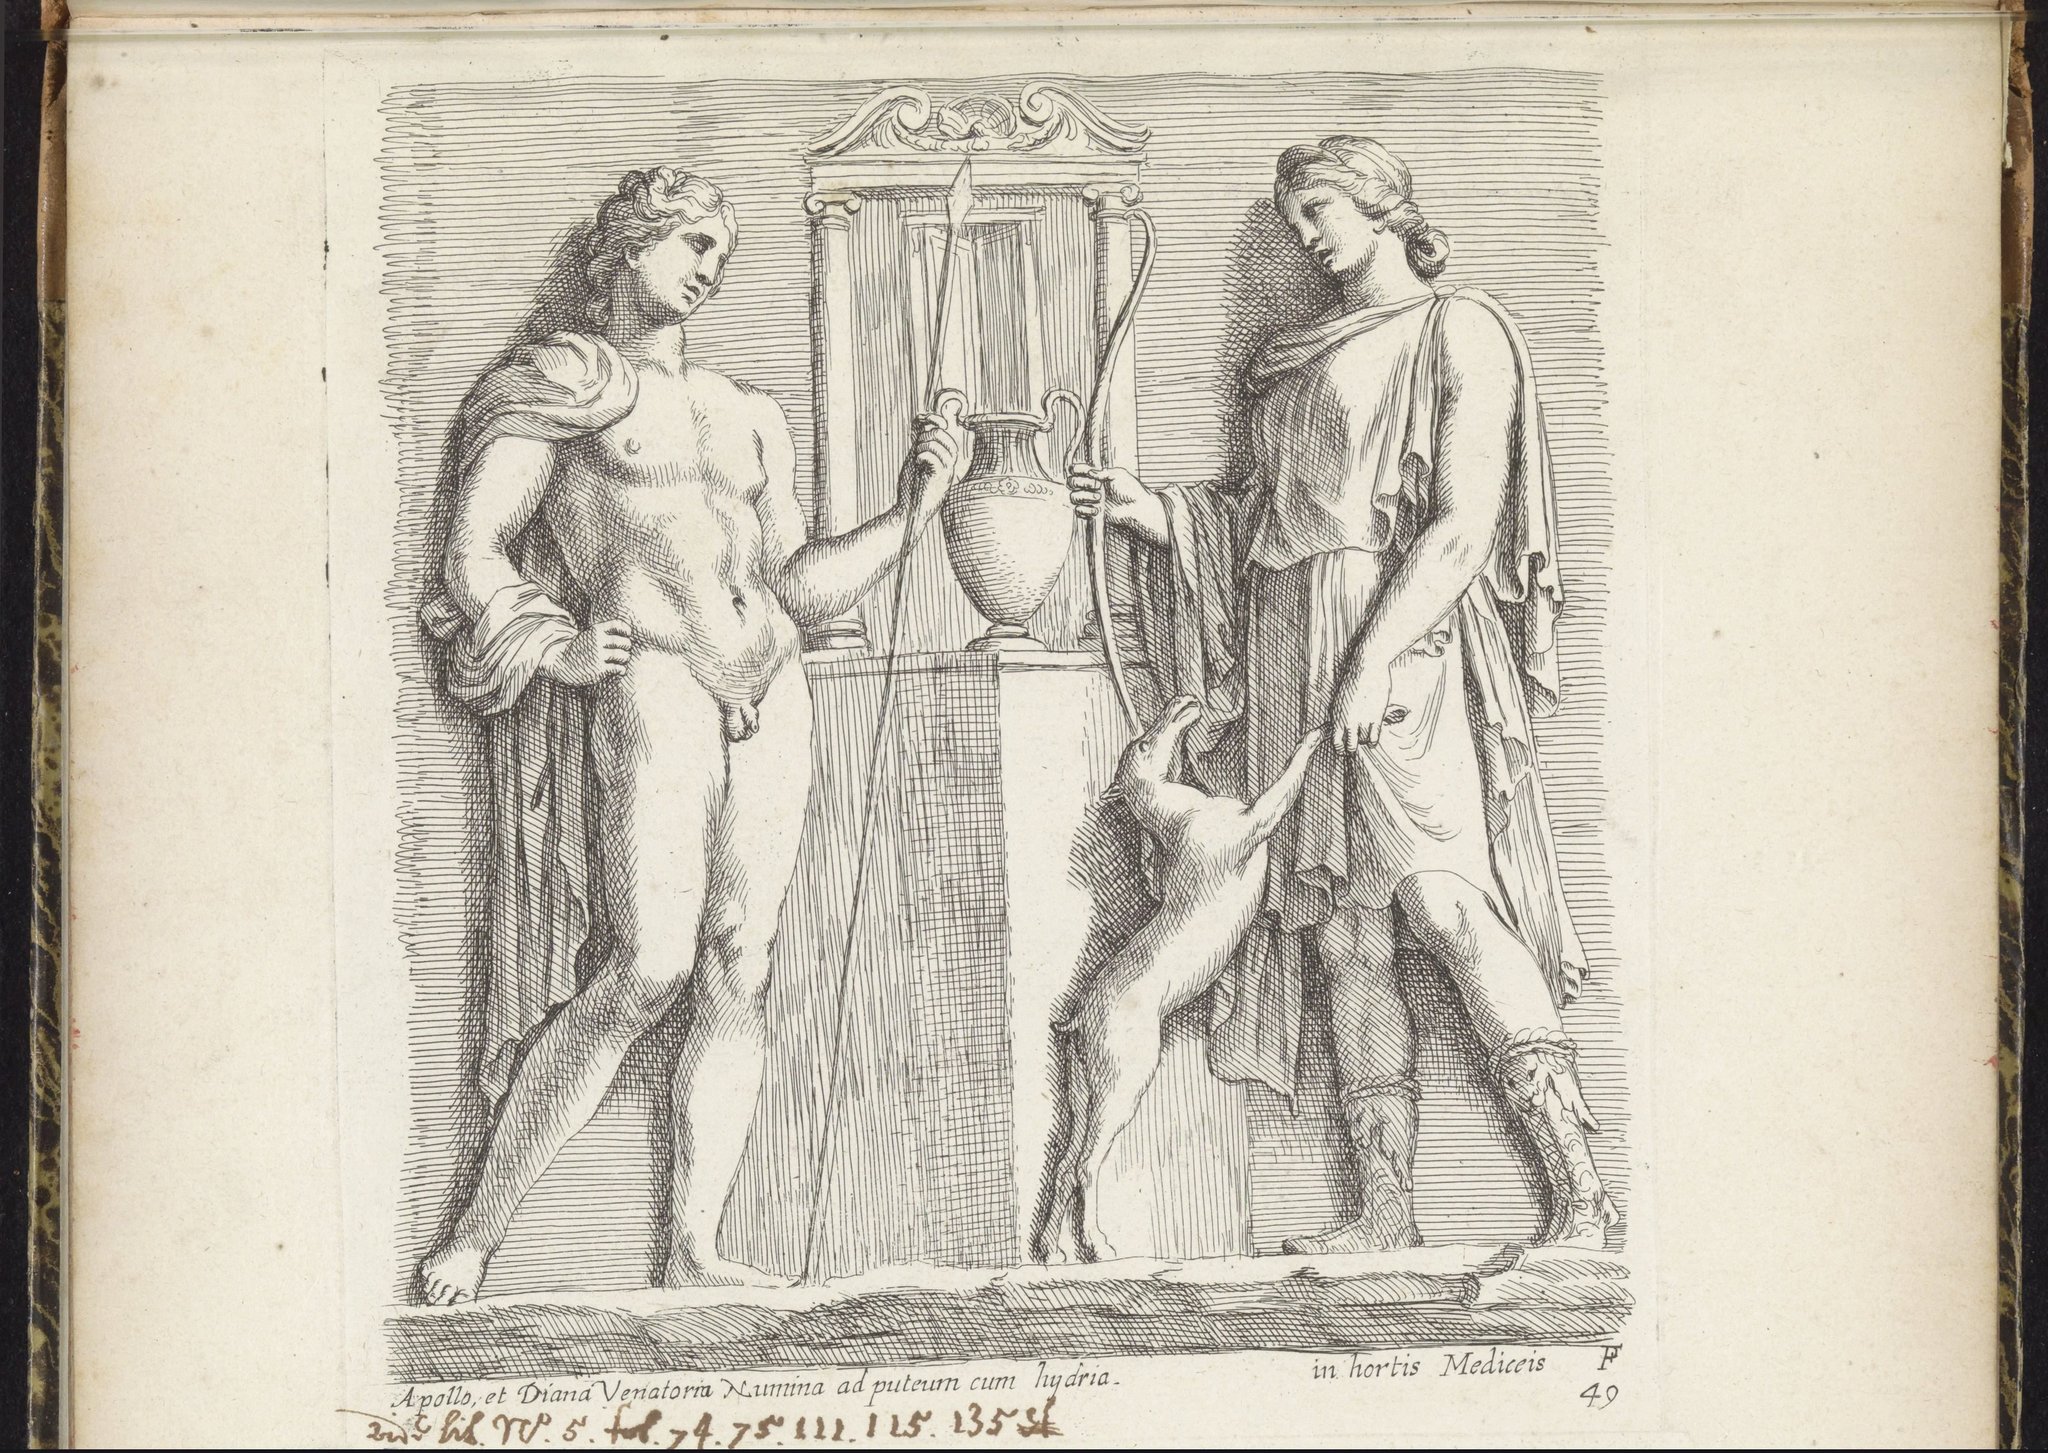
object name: print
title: Reliëf met een treurende vrouw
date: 1645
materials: paper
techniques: etching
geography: paris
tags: washing another person's feet, pain, sorrow, sadness; 'dolore', 'dolore di zeusi' (ripa), piece of sculpture, reproduction of a piece of sculpture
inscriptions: inscription: ‘Ende lib. No. 5. fol. 66 et 116.’, number: ‘77’, inscription: ‘Ende lib. No. 5 fol. 64 et 65.’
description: Deze prent maakt deel uit van een reeks van 54 prenten (+ titelprent) naar antieke reliëfs. De nummering op de prenten loopt van 1 tot en met 50. Sommige prenten hebben dubbele nummers. Naar een reliëf in het Palazzo della Valle te Rome.